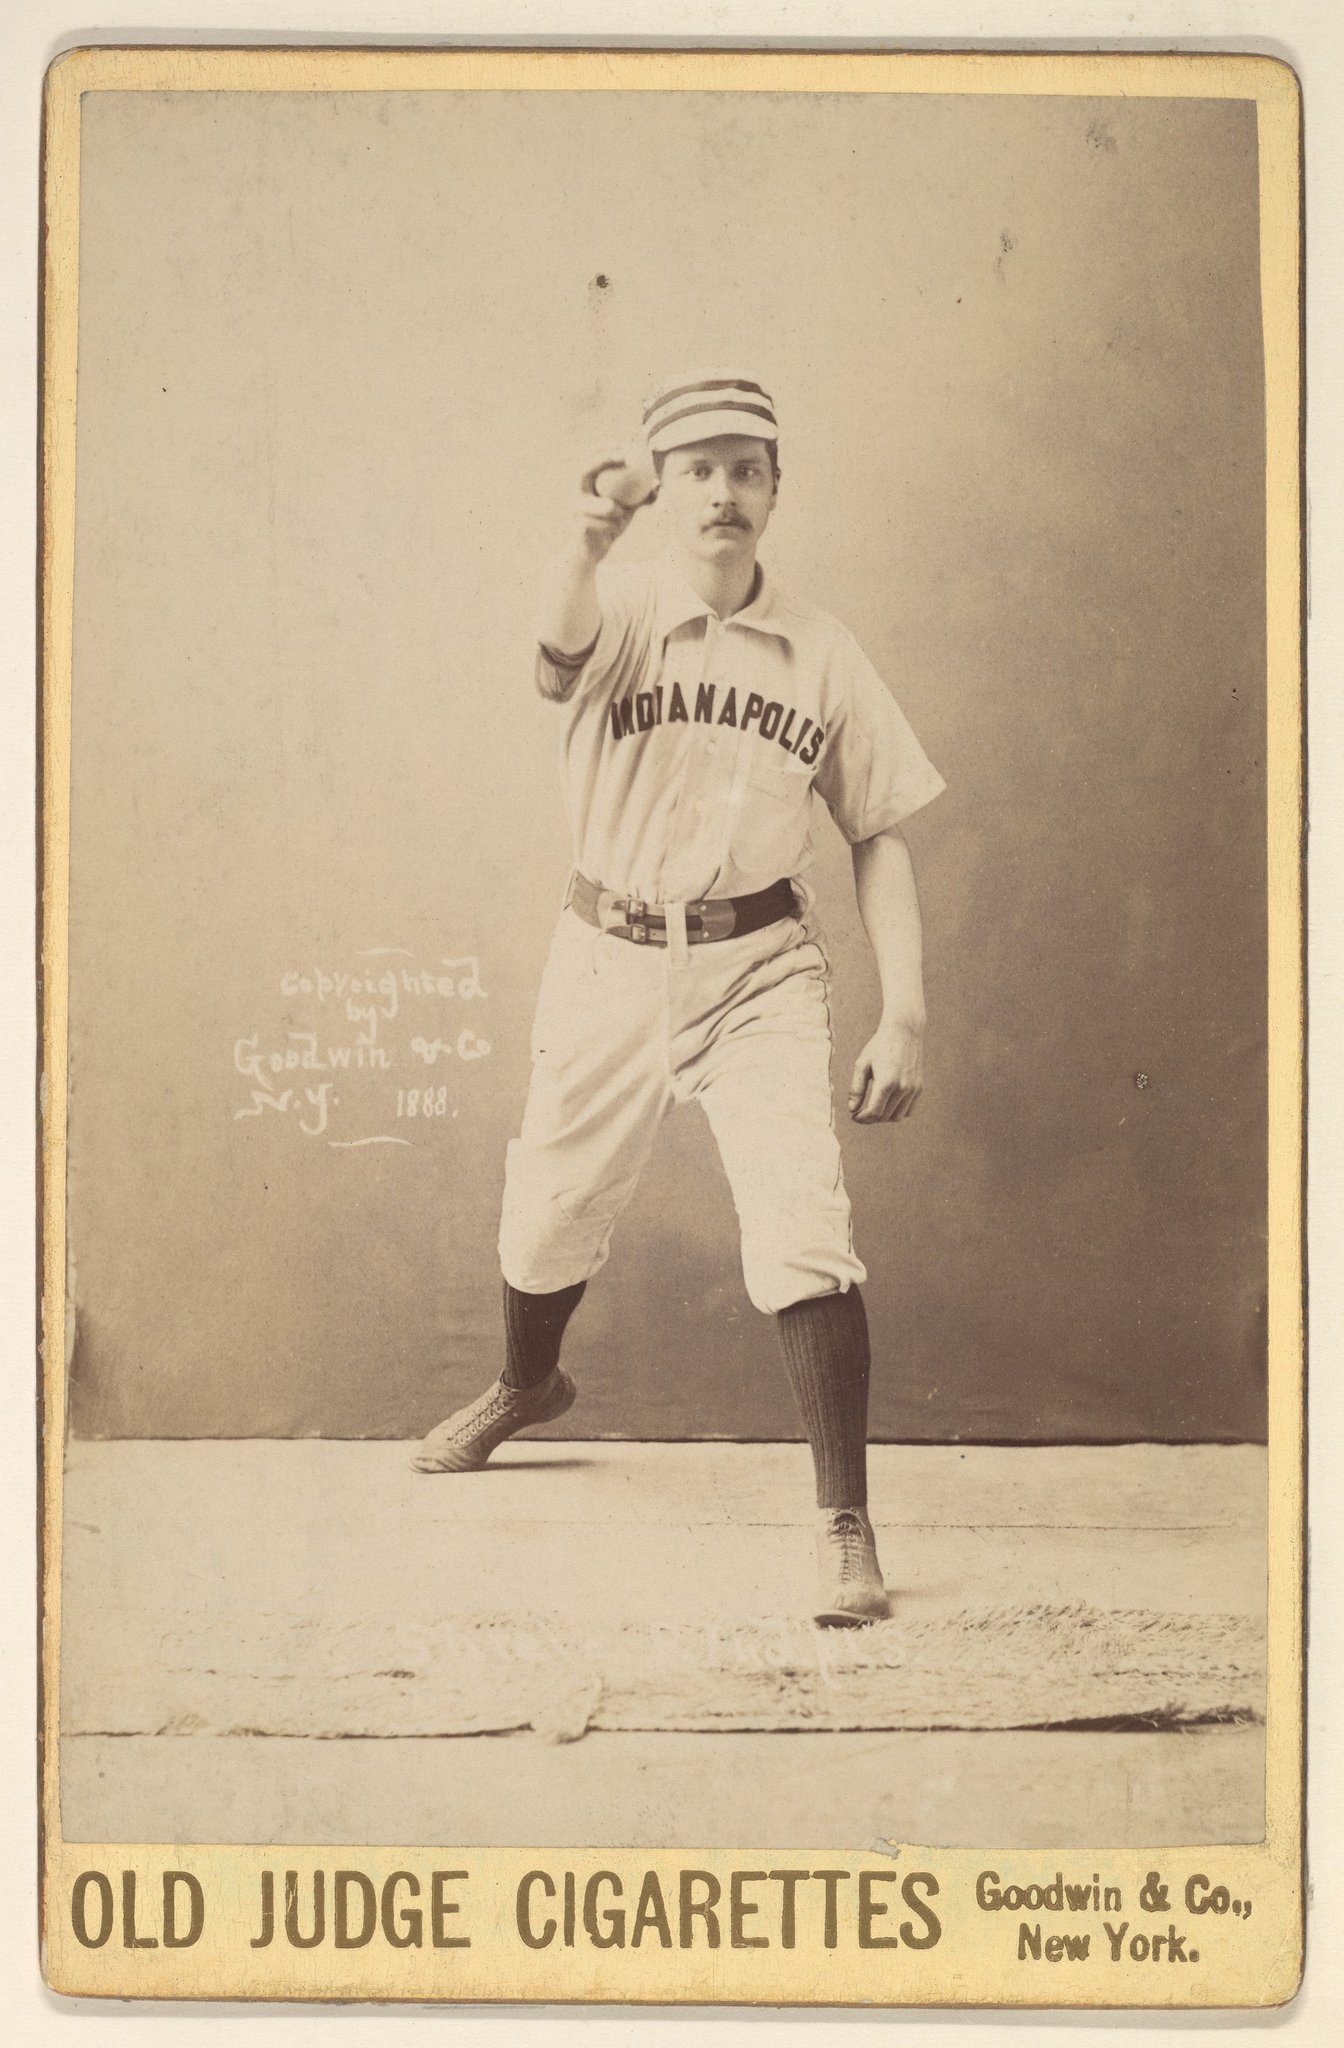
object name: baseball card, photograph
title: Shreve, Pitcher, Indianapolis, from the series Old Judge Cigarettes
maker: goodwin & company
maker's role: publisher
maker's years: 1850-1950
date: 1888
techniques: albumen silver print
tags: men,portraits,baseball,athletes